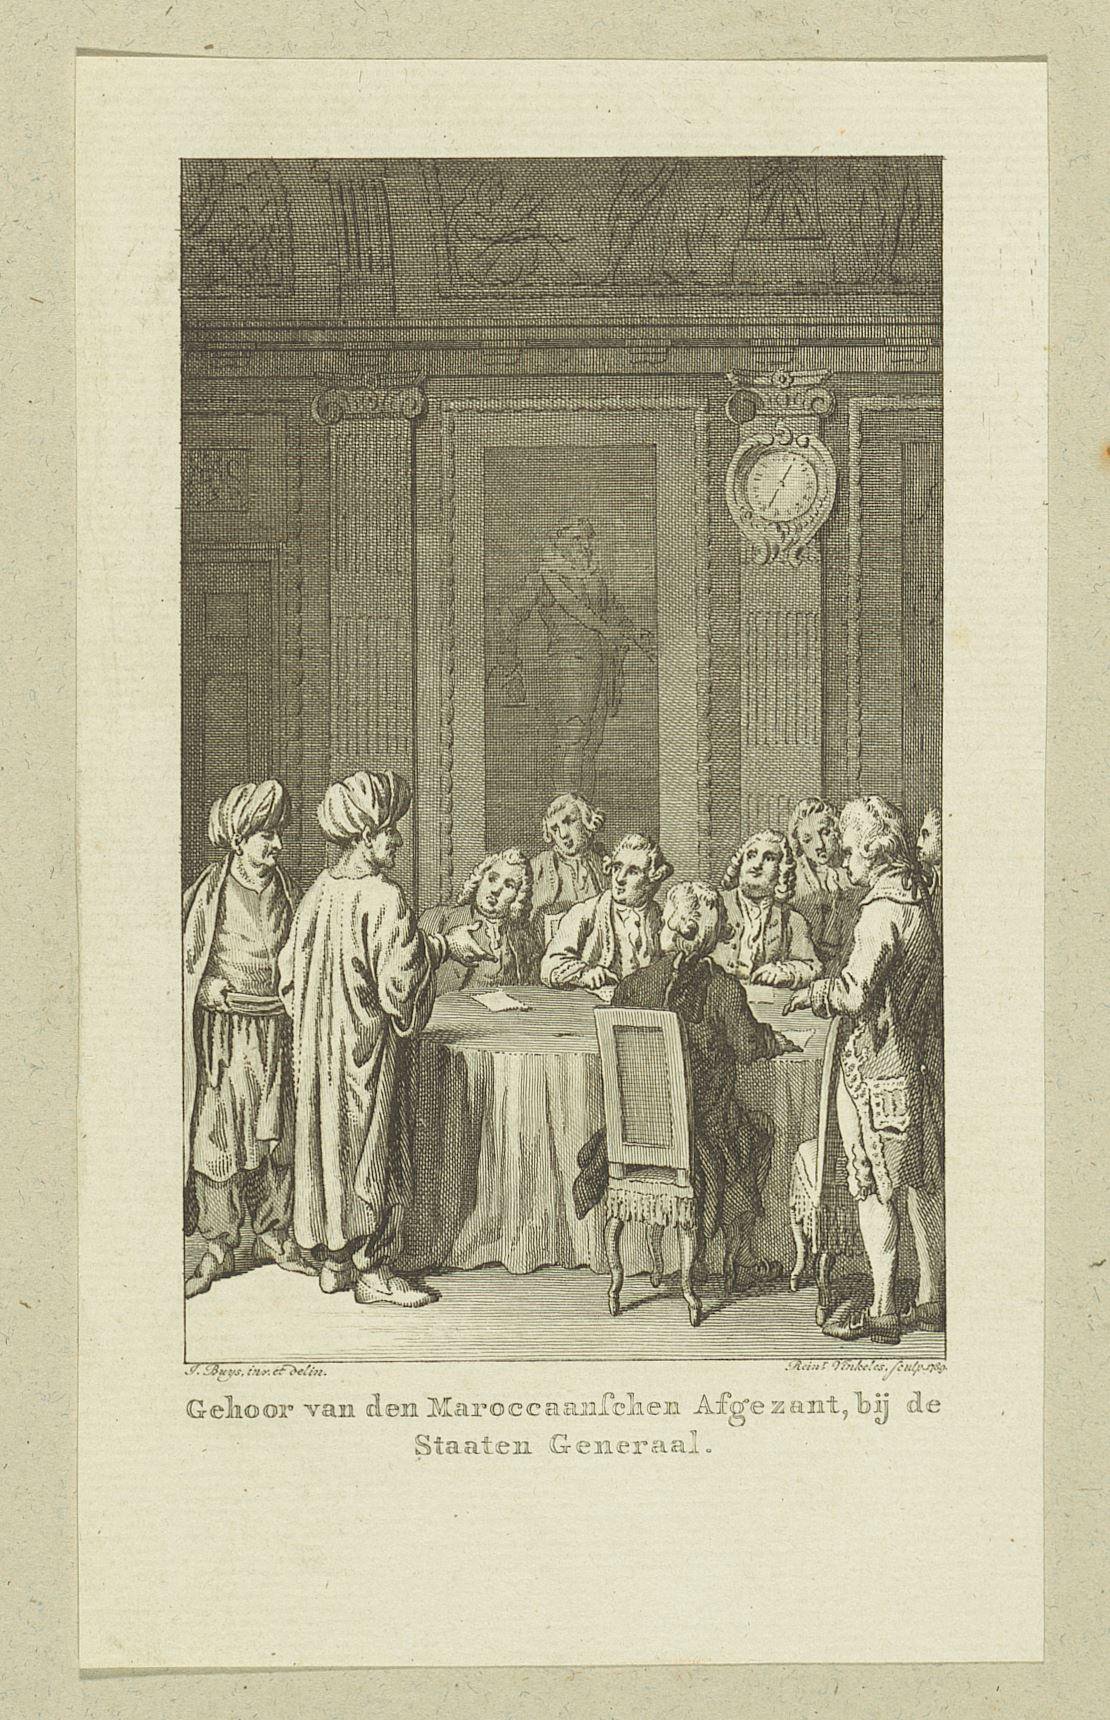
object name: history print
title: Marokkaanse afgezant op gehoor bij de Staten-Generaal, 1770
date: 1789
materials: paper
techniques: engraving, etching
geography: northern netherlands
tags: the hague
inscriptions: date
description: Huidige staat van prent ook gebruikt in: Loosjes, P.A. Vaderlandsche historie, vervattende de geschiedenissen der Vereenigde Nederlanden (…) Ten vervolge van Wagenaars Vaderlandsche historie. 48 delen. Amsterdam: Johannes Allart, 1786-1811, dl. 24 (1789), tussen p. 190 en 191.